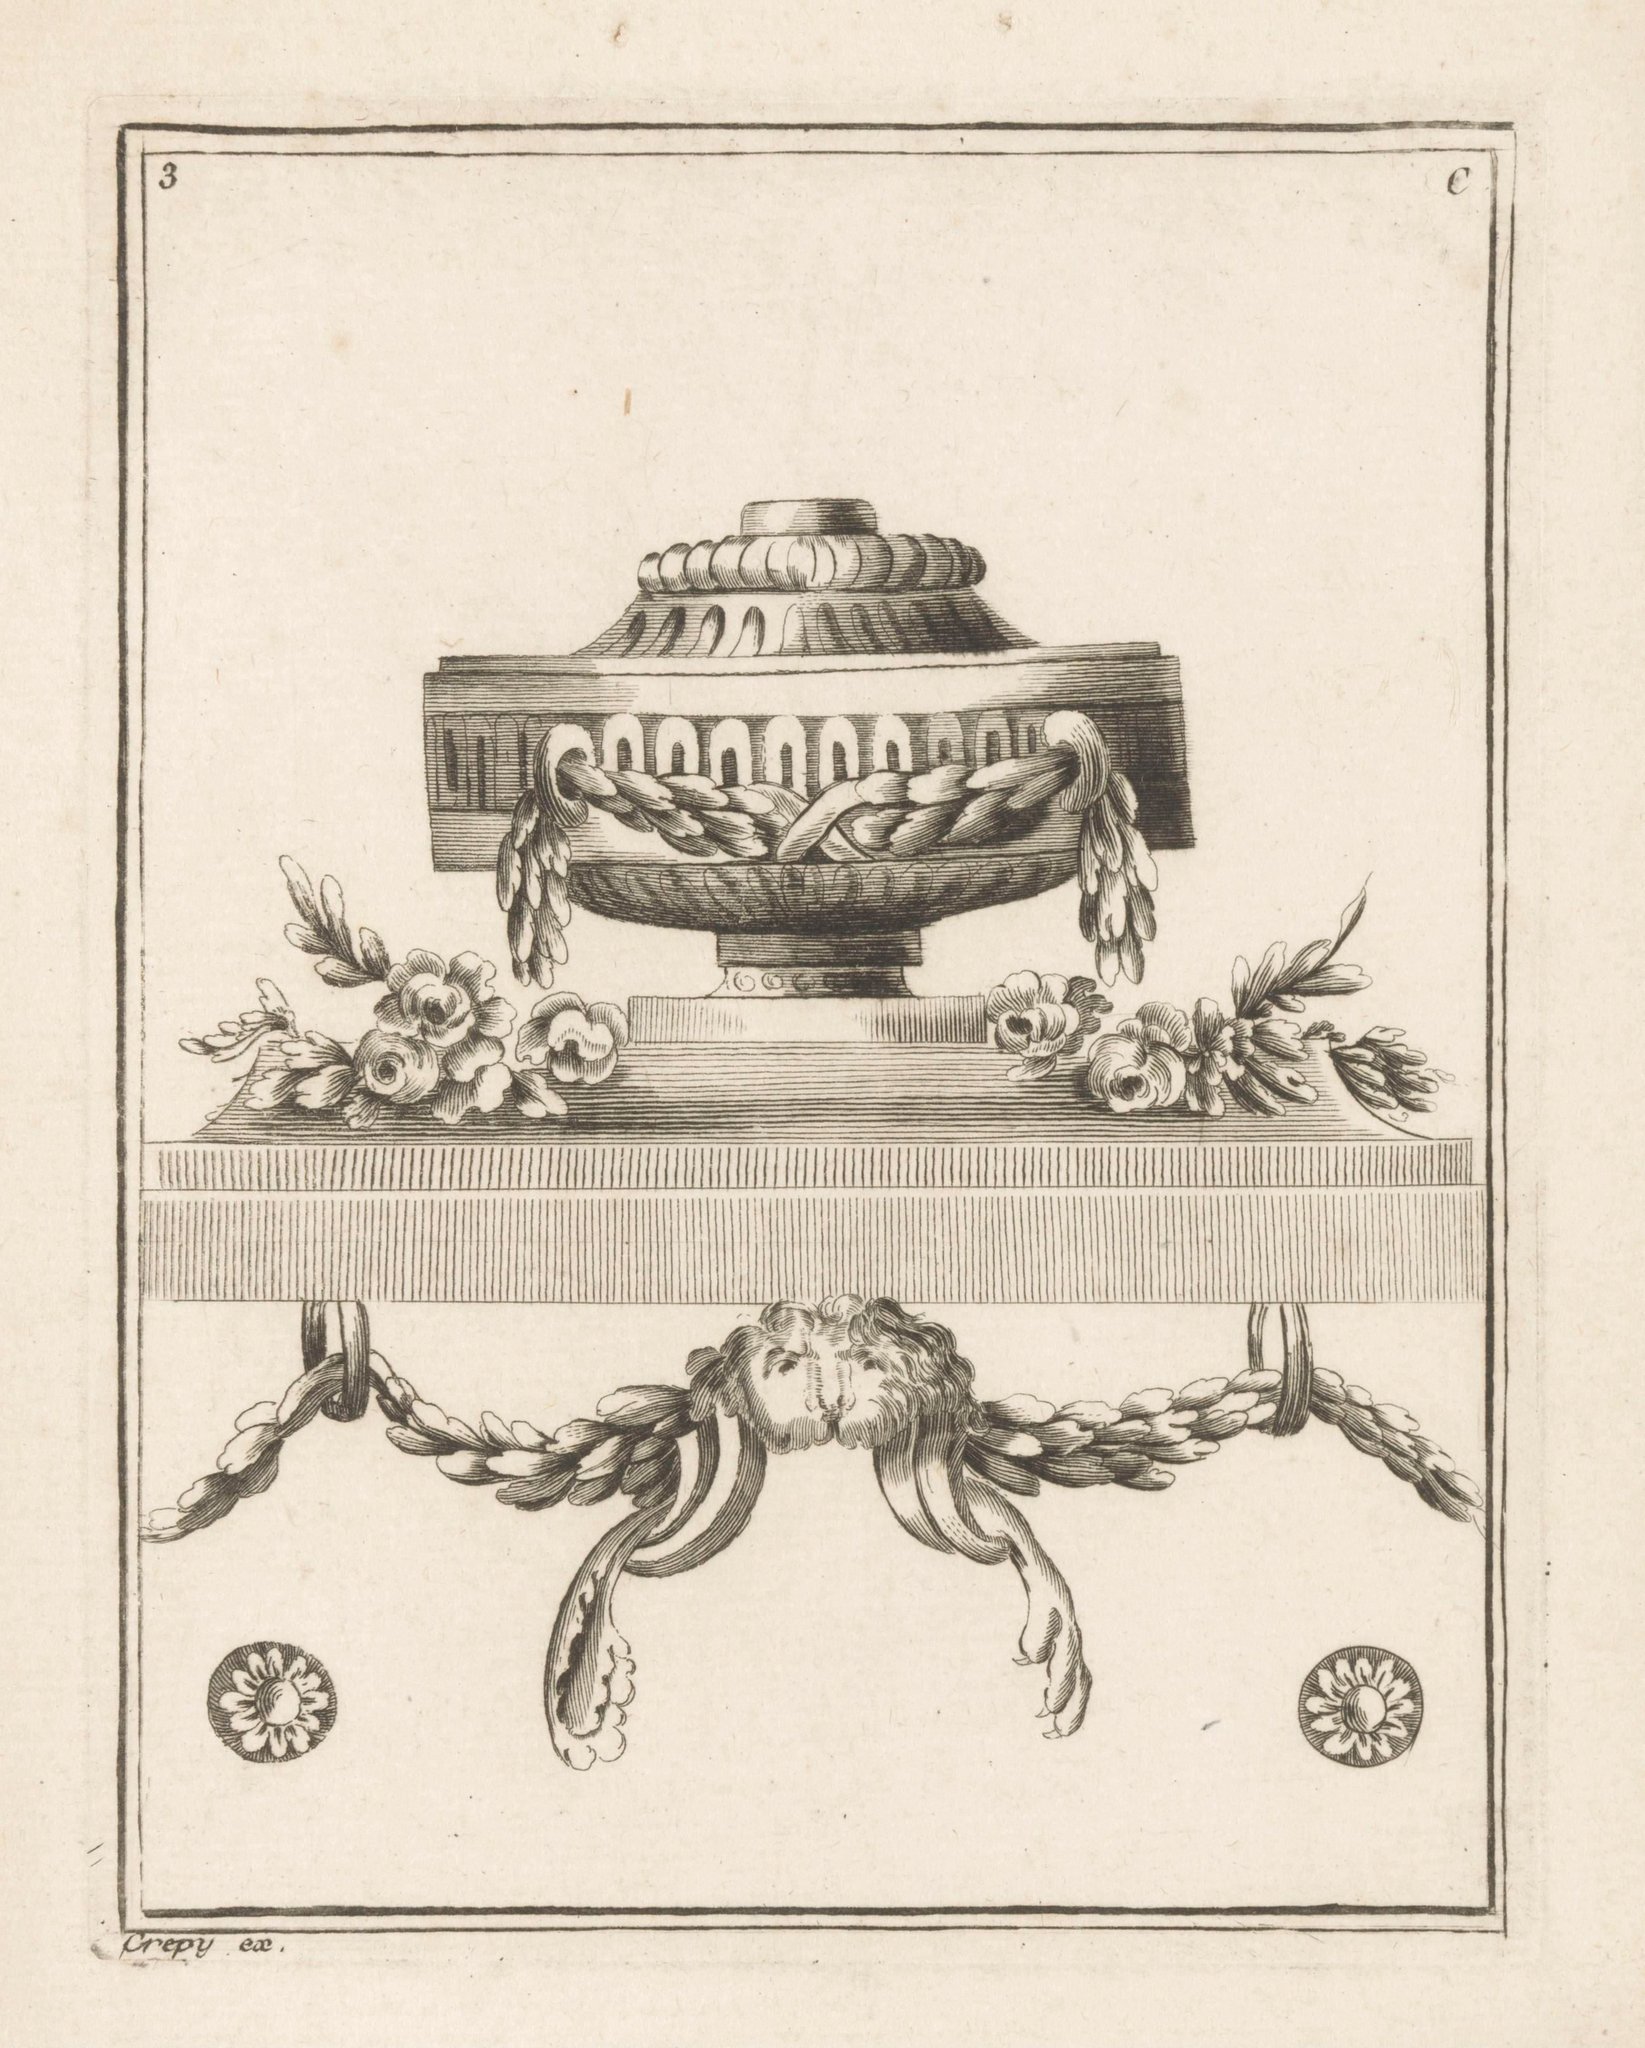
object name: print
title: Vaas met bloemen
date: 1770-1780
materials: paper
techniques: etching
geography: paris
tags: flowers, vase ~ ornament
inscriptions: collector's mark: Lugt 2760, collector's mark: Lugt 2228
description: Een geornamenteerde vaas geflankeerd door bloemen. Daaronder een guirlande met leeuwenkop.